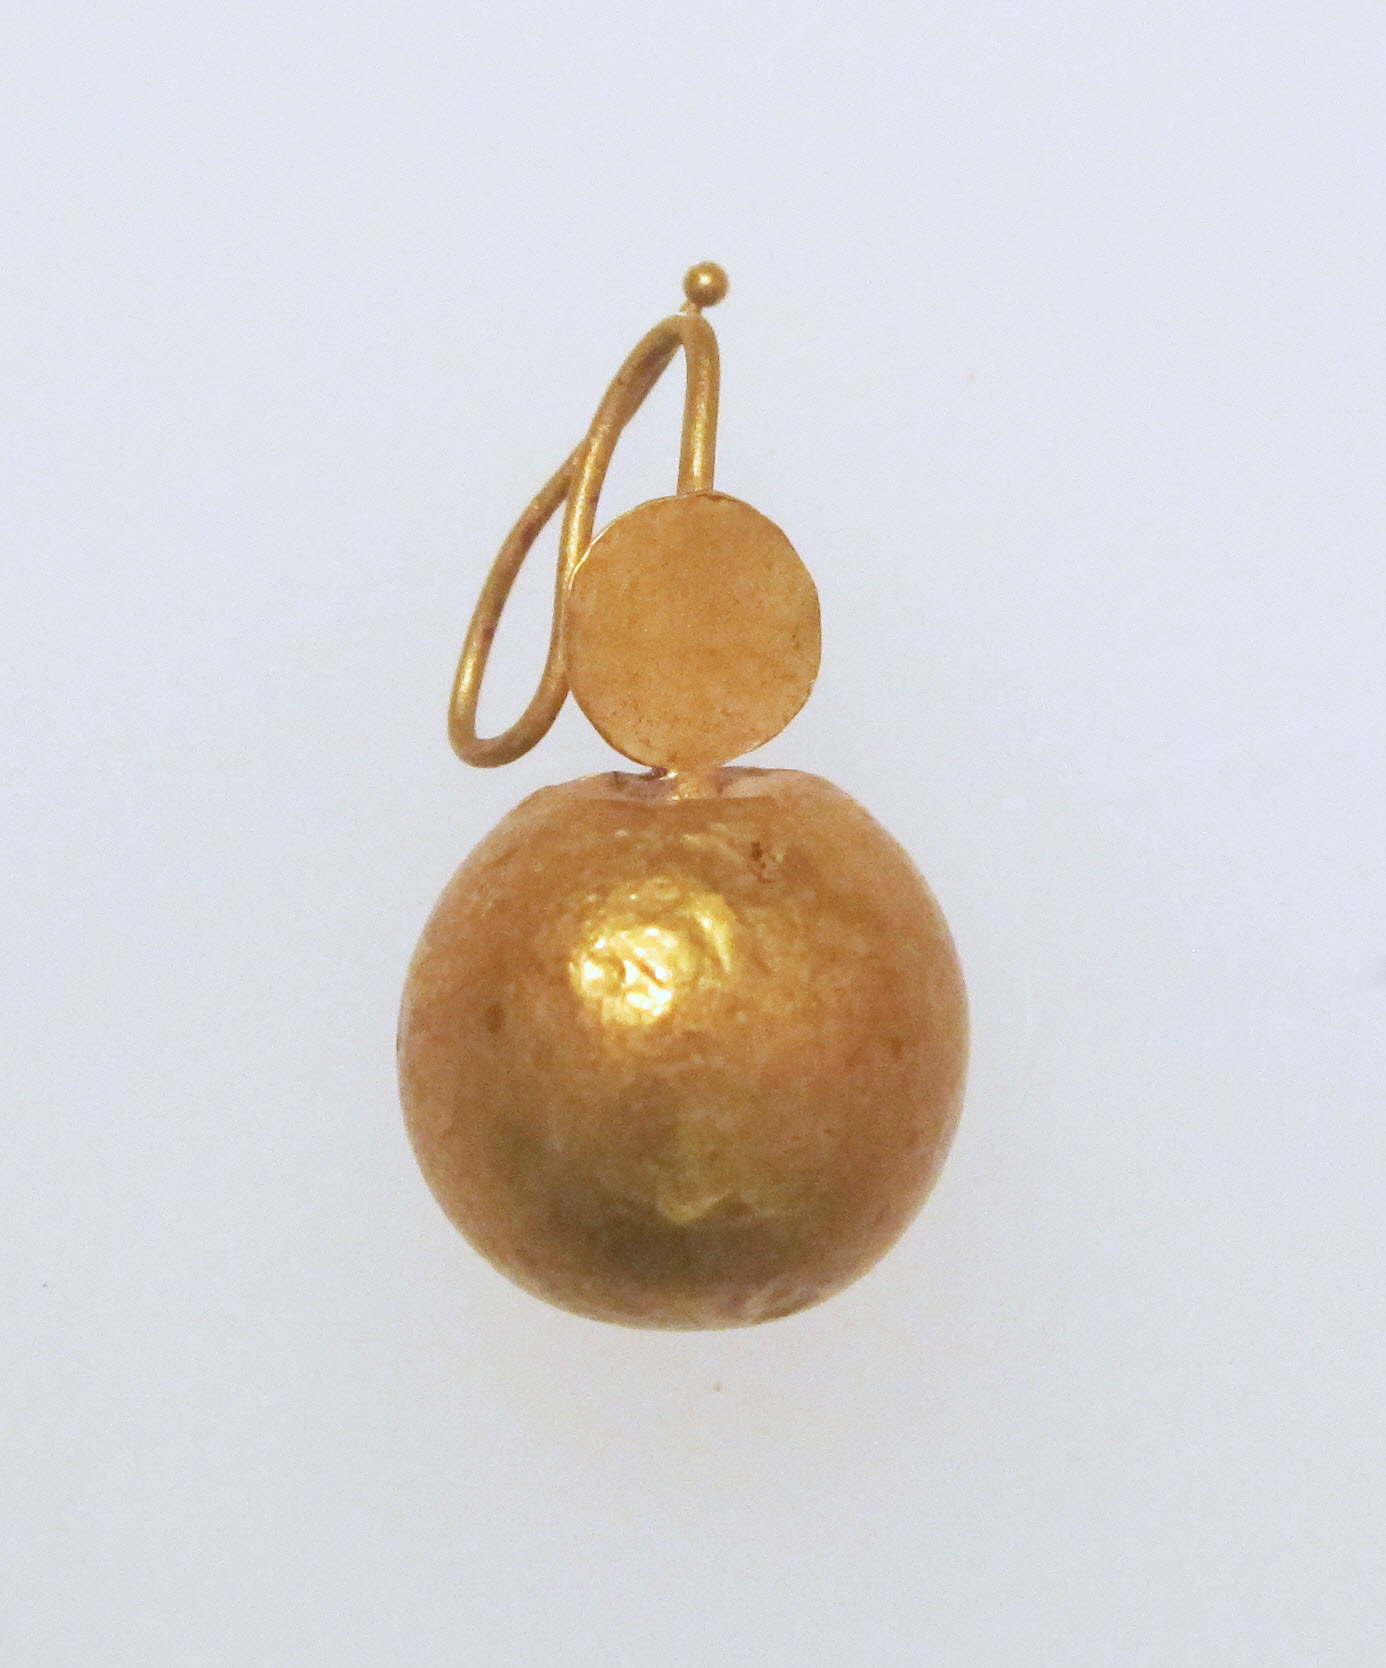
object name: earring hook type with sphere end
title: Earring-hook type with sphere ends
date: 7000 BCE-330 CE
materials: gold